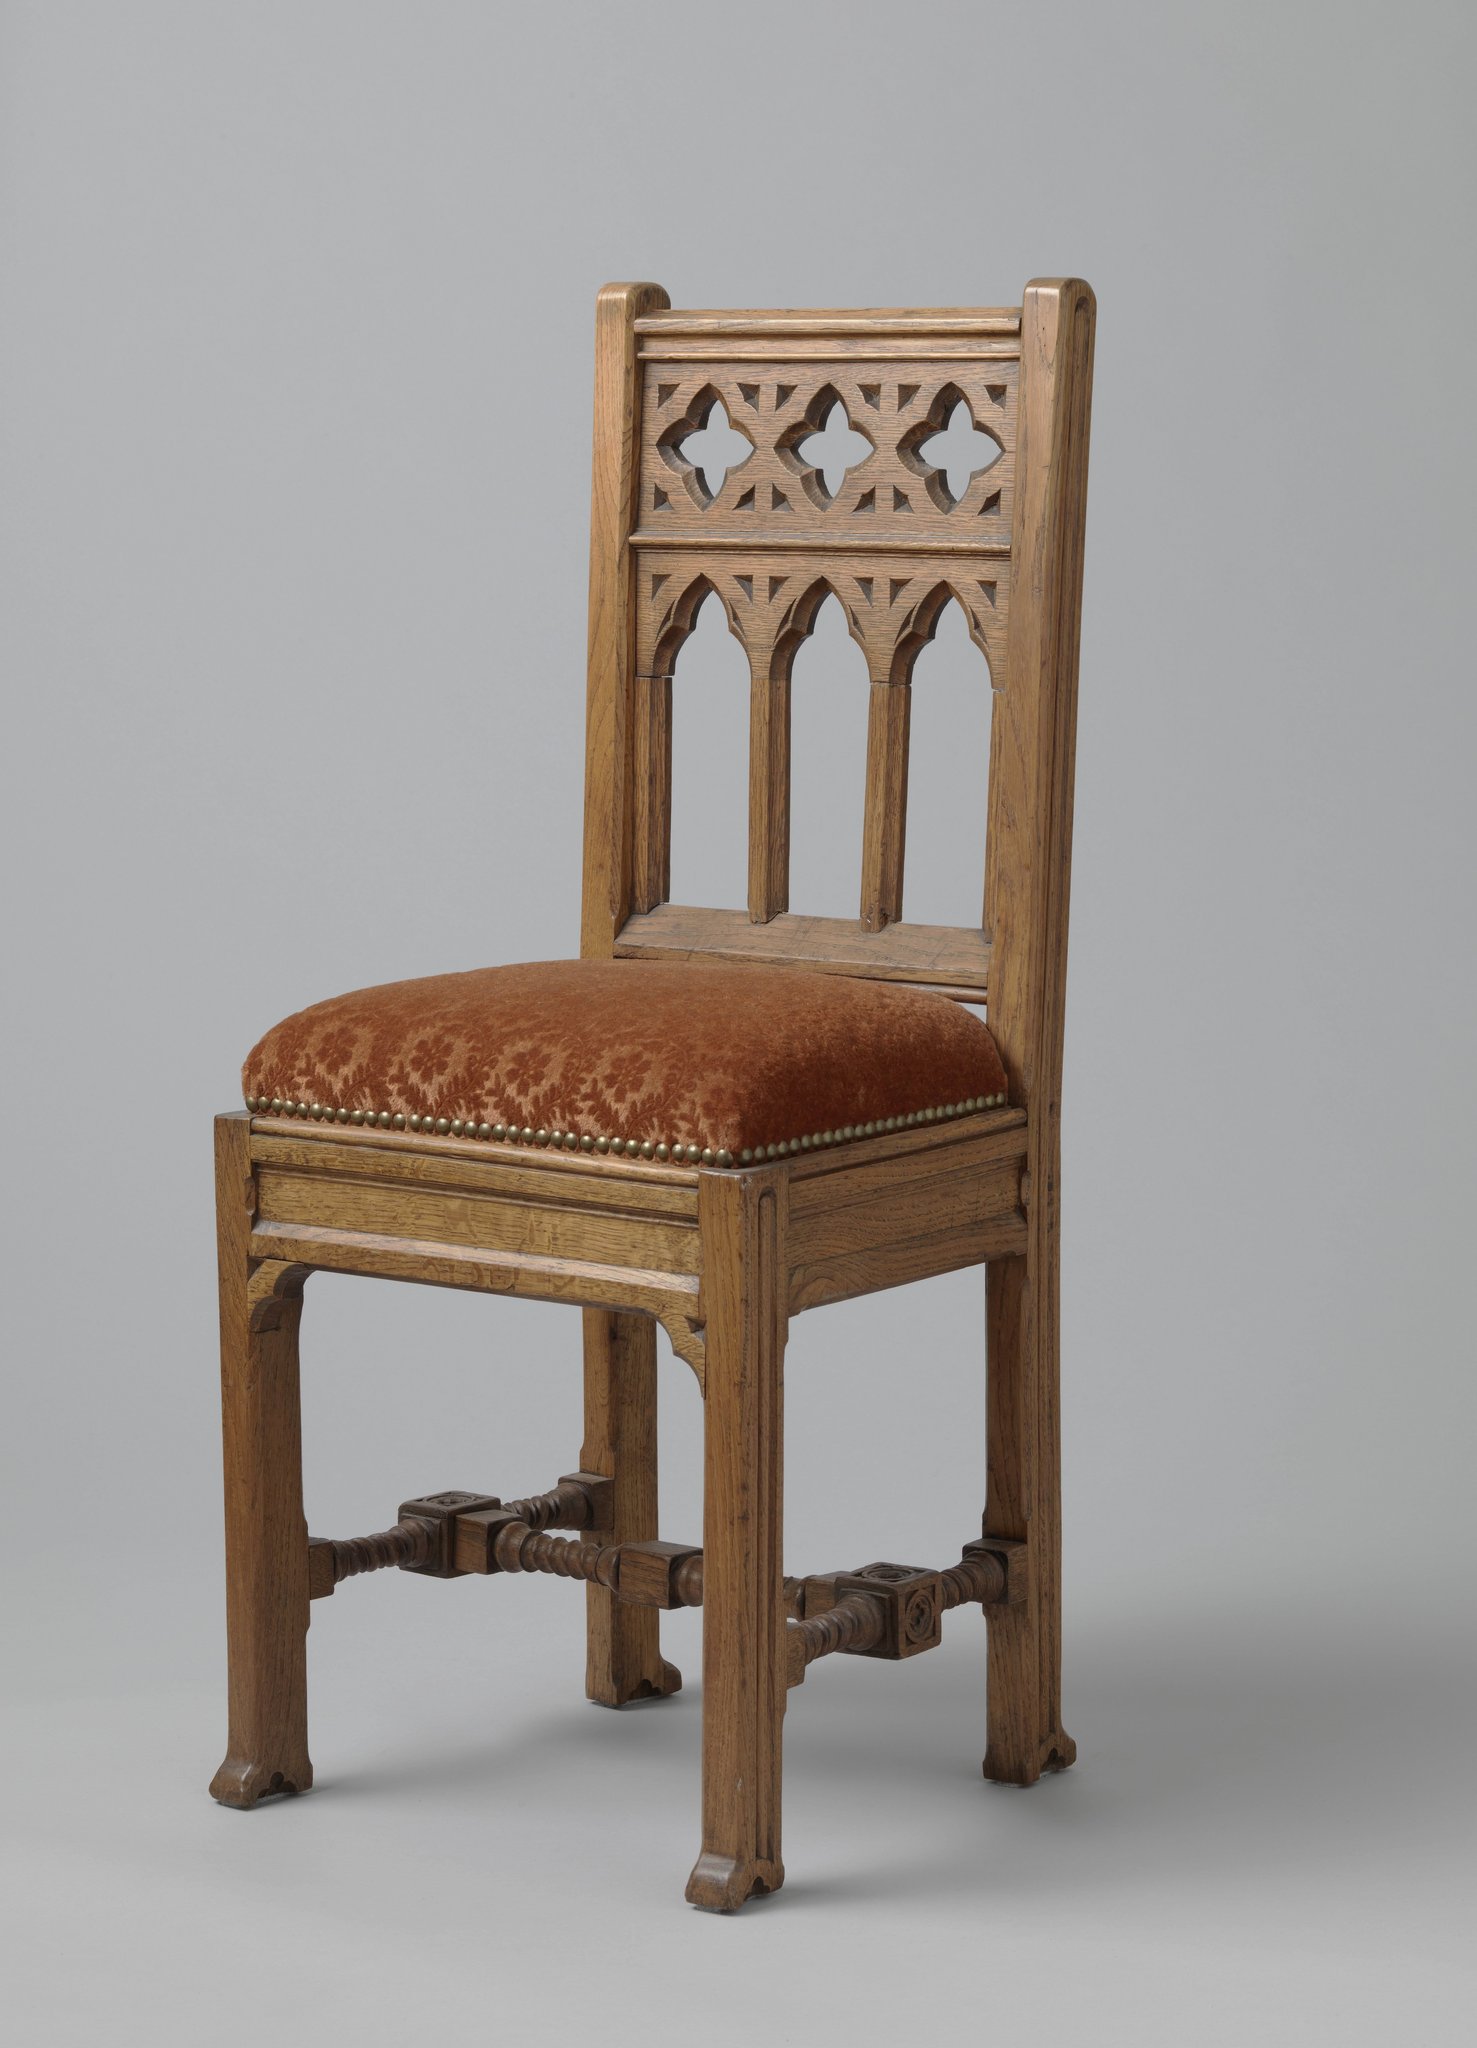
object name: furniture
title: Stoel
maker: pierre joseph hubert cuypers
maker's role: draughtsman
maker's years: 1827-1921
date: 1850-1860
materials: wood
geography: roermond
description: Stoel in gotische stijl. Bekleed met rood trijp.